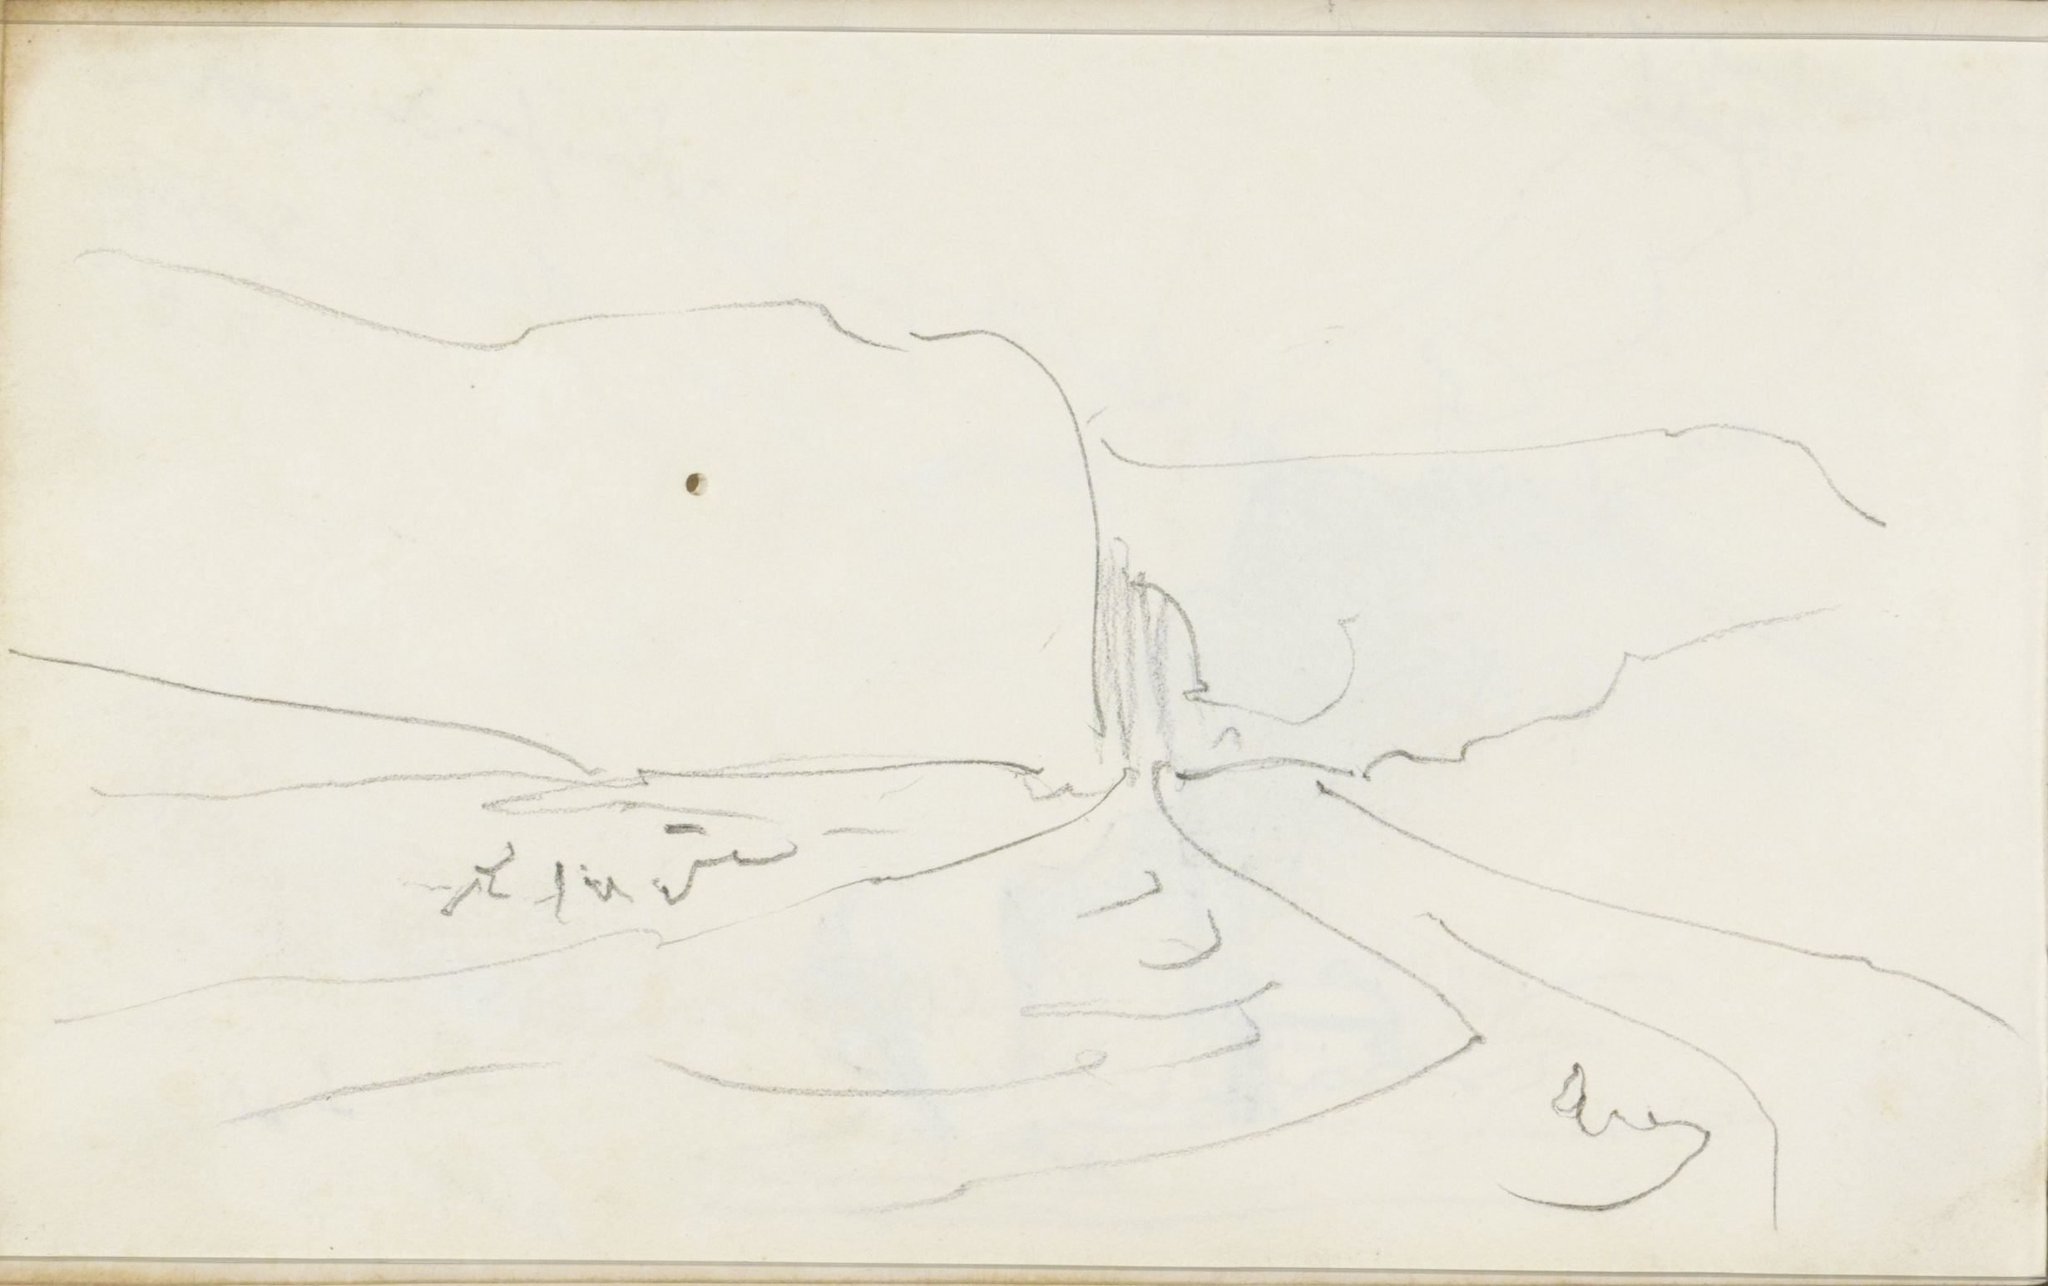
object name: sketchbook leaf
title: Rivierlandschap met bergen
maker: johannes tavenraat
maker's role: draughtsman, painter, print maker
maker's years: 1809-1881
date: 1840-1841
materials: paper, pencil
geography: meuse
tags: landscapes with waters, waterscapes, seascapes (in the temperate zone), mountains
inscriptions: annotation: ‘[...]’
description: Blad 15 verso uit een schetsboek met 41 bladen.